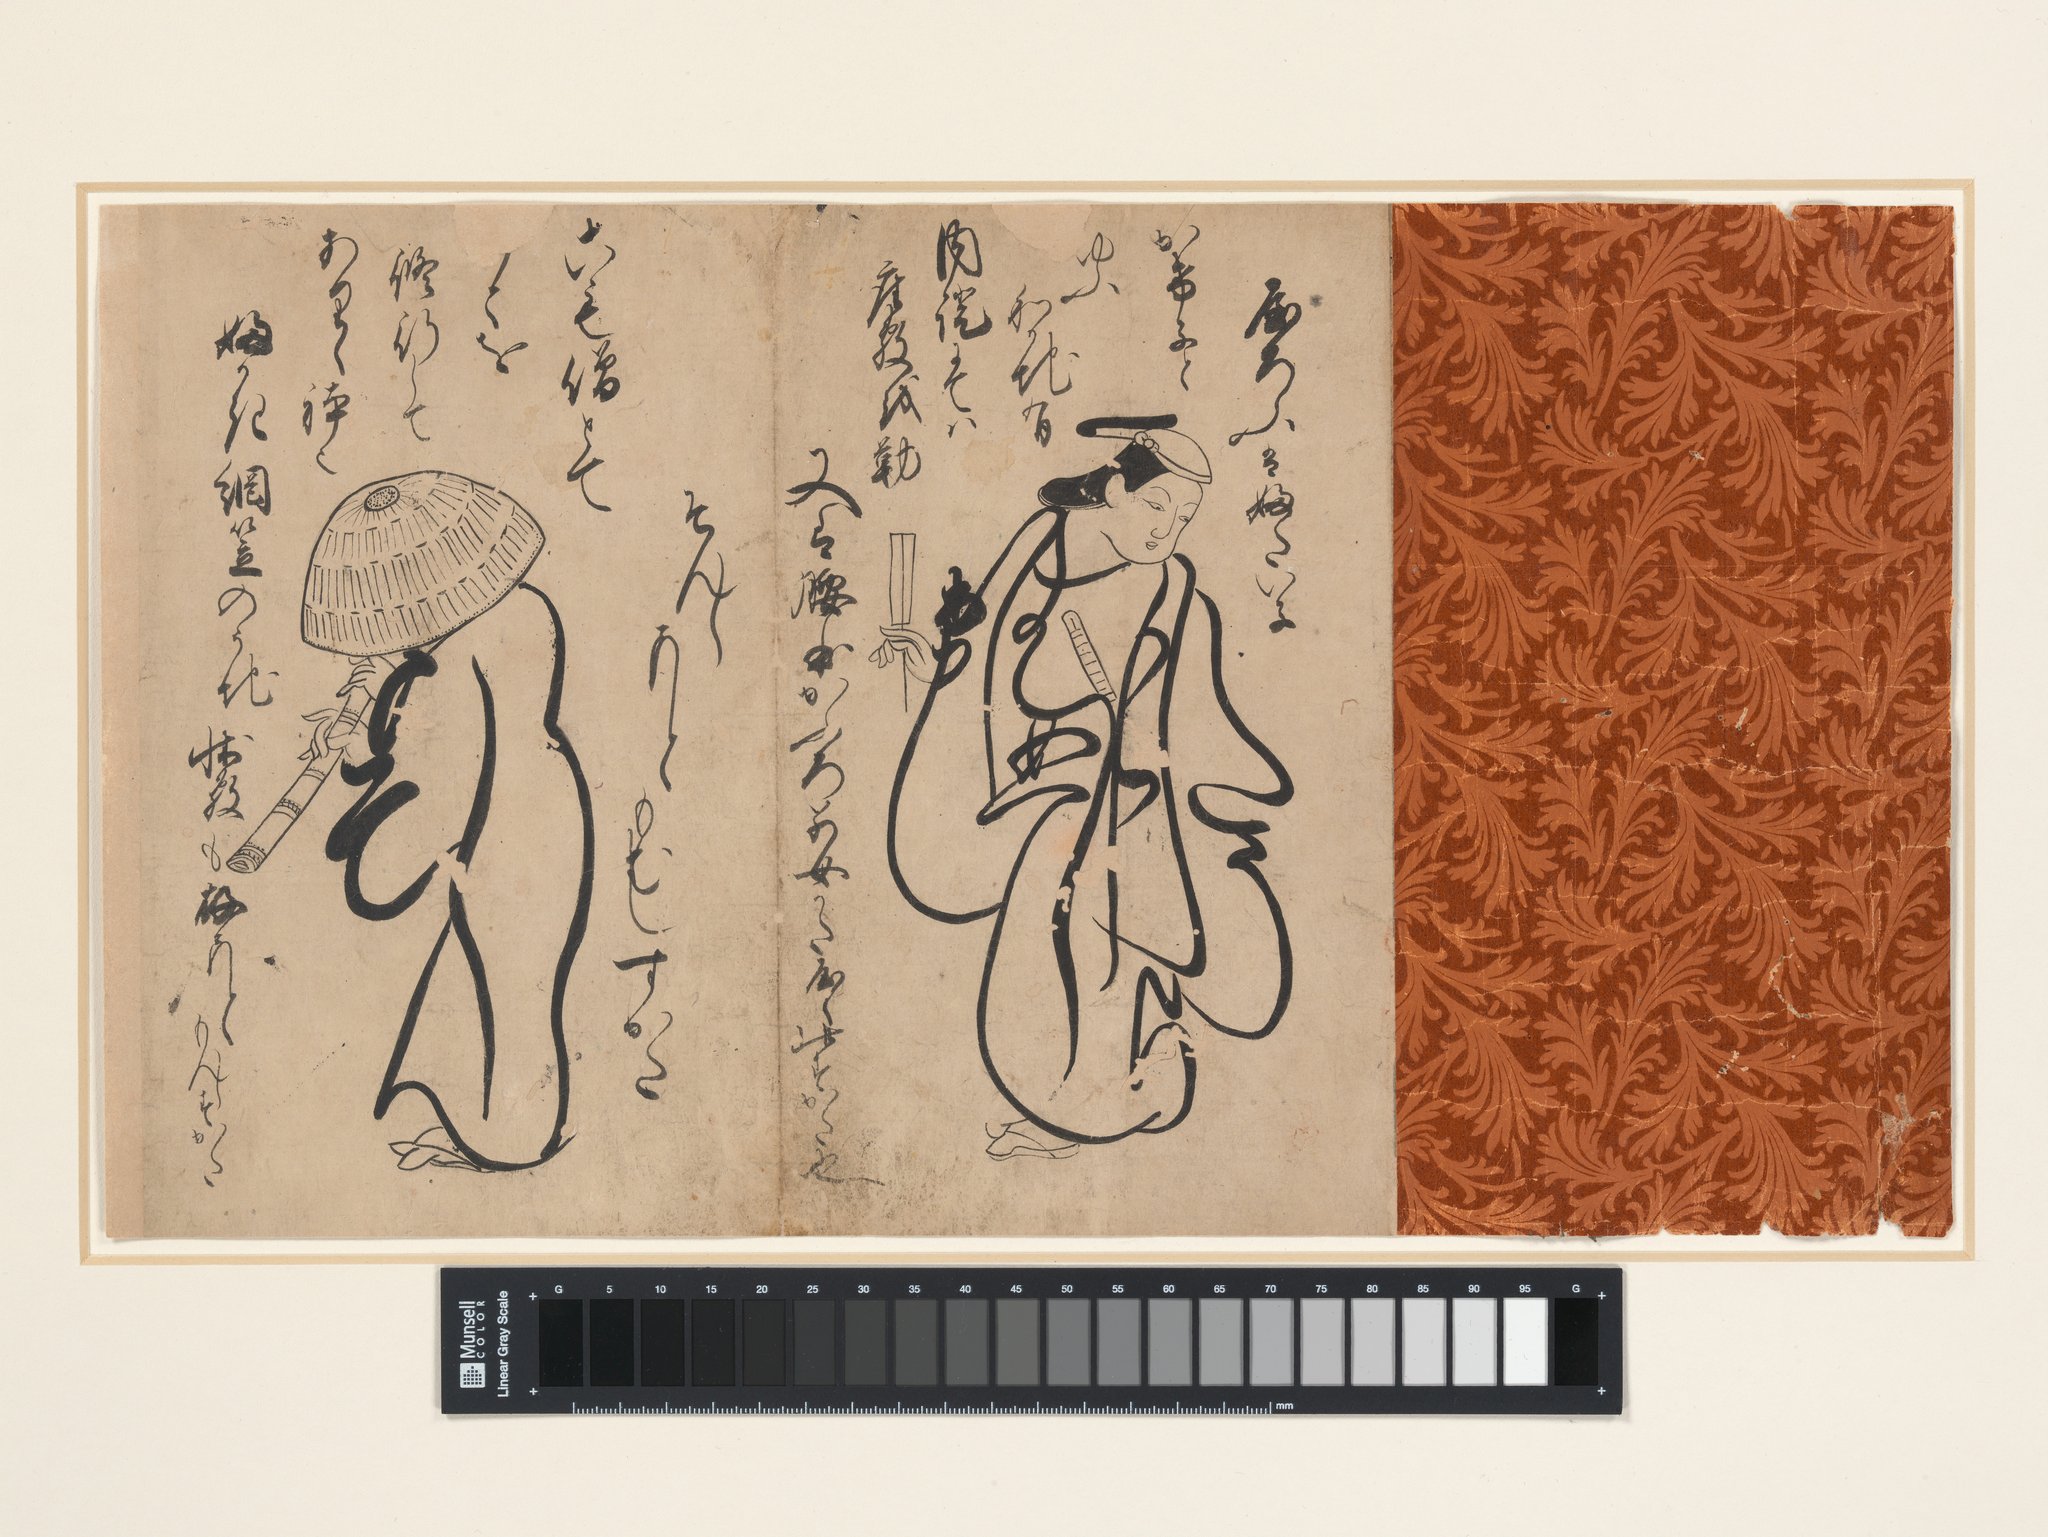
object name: painting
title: Pictures with Letters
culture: japanese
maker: iwasa matabei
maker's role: artist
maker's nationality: japanese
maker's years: 1578-1650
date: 1601-1700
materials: ink, paper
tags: women